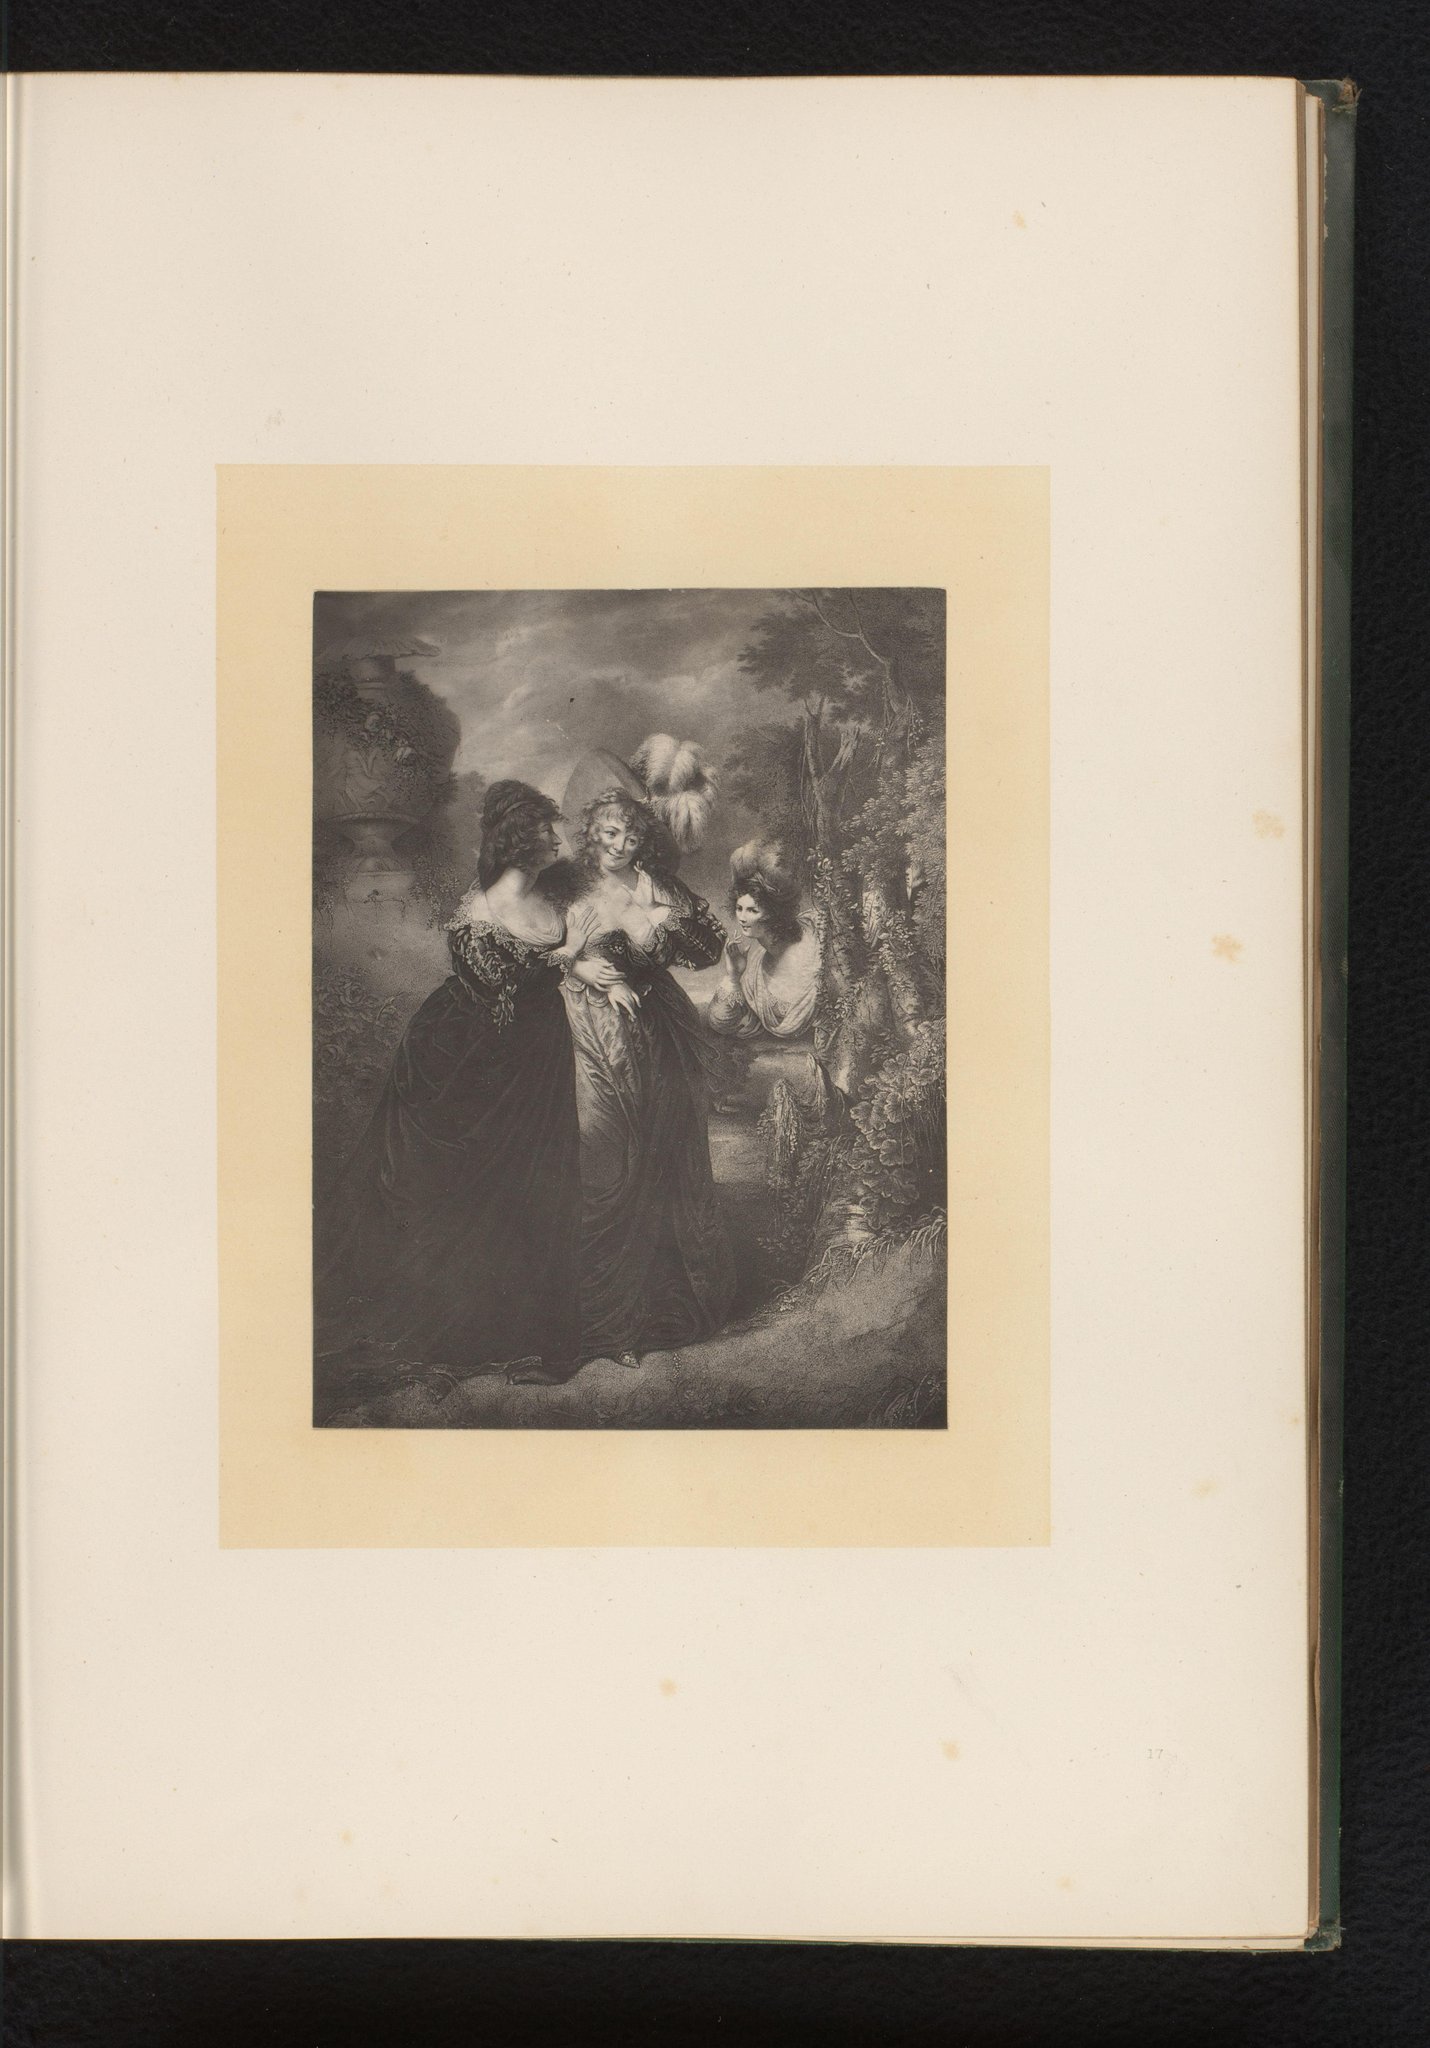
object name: reproduction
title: Much about Nothing, Act III, Scene 1: An Orchard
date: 1874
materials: paper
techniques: woodburytype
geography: london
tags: (shakespeare, much ado about nothing) specific works of literature (with author, title)